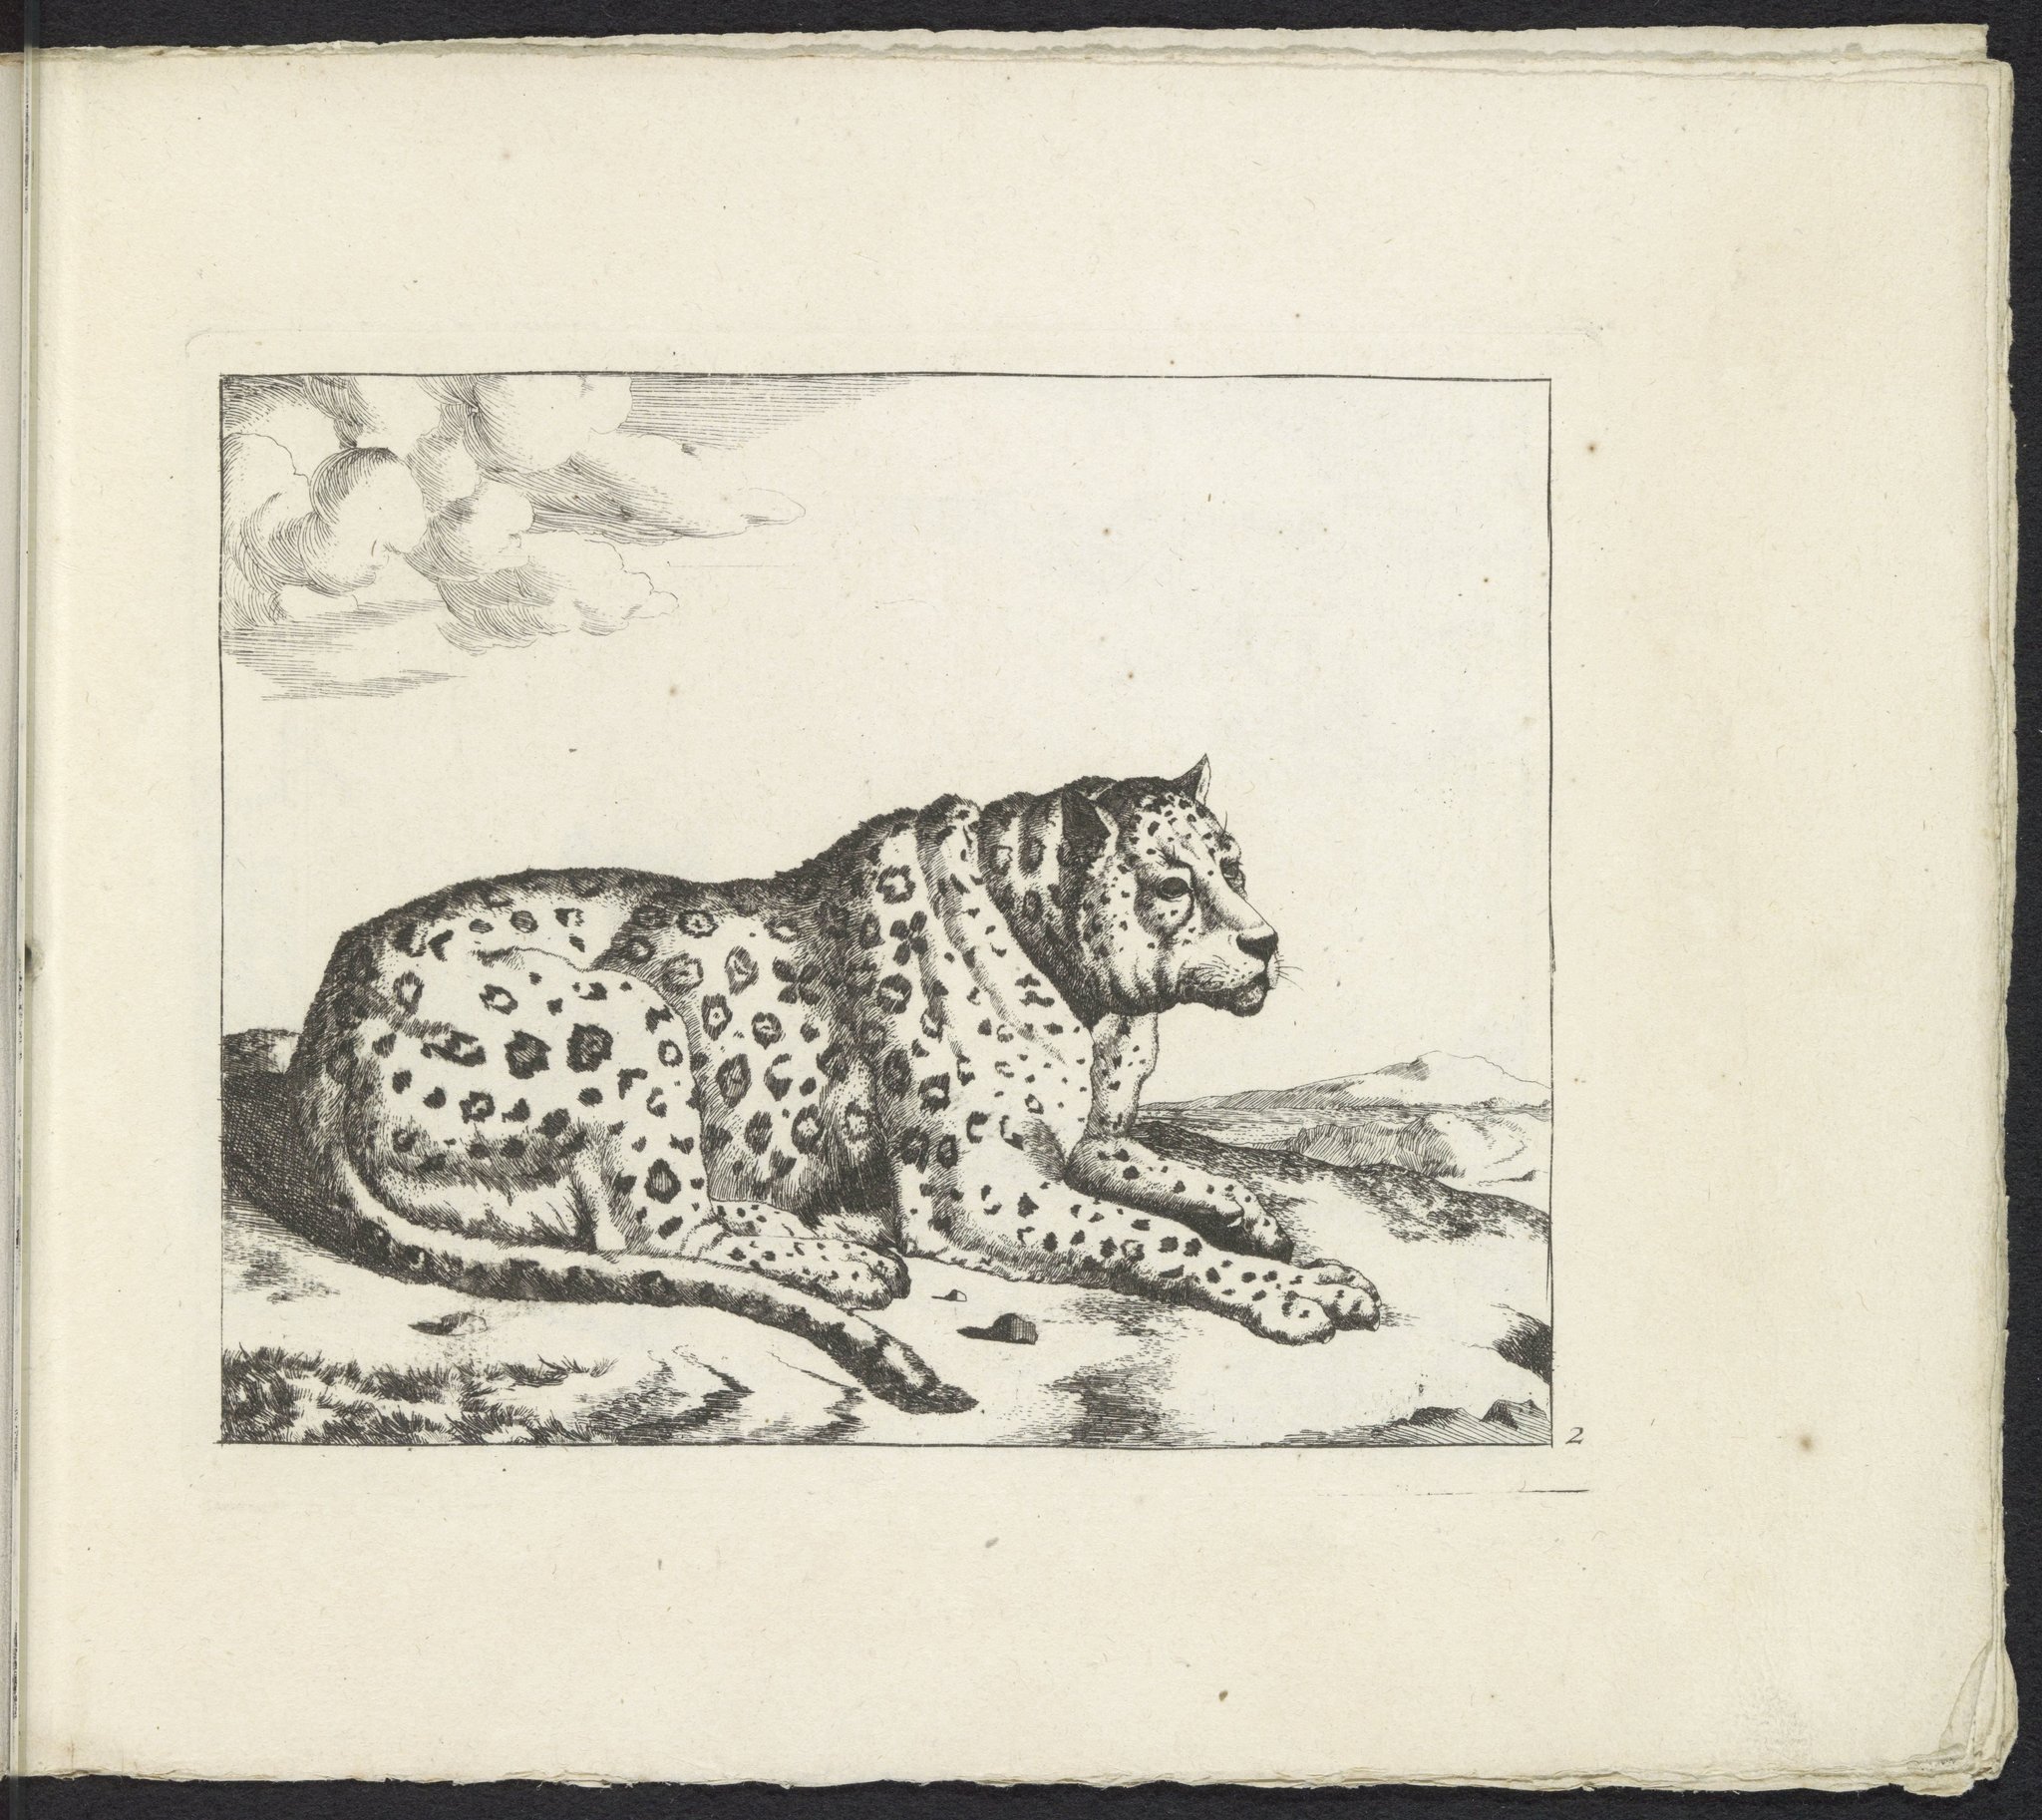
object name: print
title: Liggend luipaard, naar rechts, de staart langs het lichaam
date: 1657-1677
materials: paper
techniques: etching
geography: northern netherlands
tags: beasts of prey, predatory animals: leopard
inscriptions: collector's mark: Lugt 2228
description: Liggend luipaard, naar rechts, de staart langs het lichaam. Prent uit een serie van acht genummerde prenten met ''naar het leven'' getekende luipaarden, de reeks aan bindtouw.